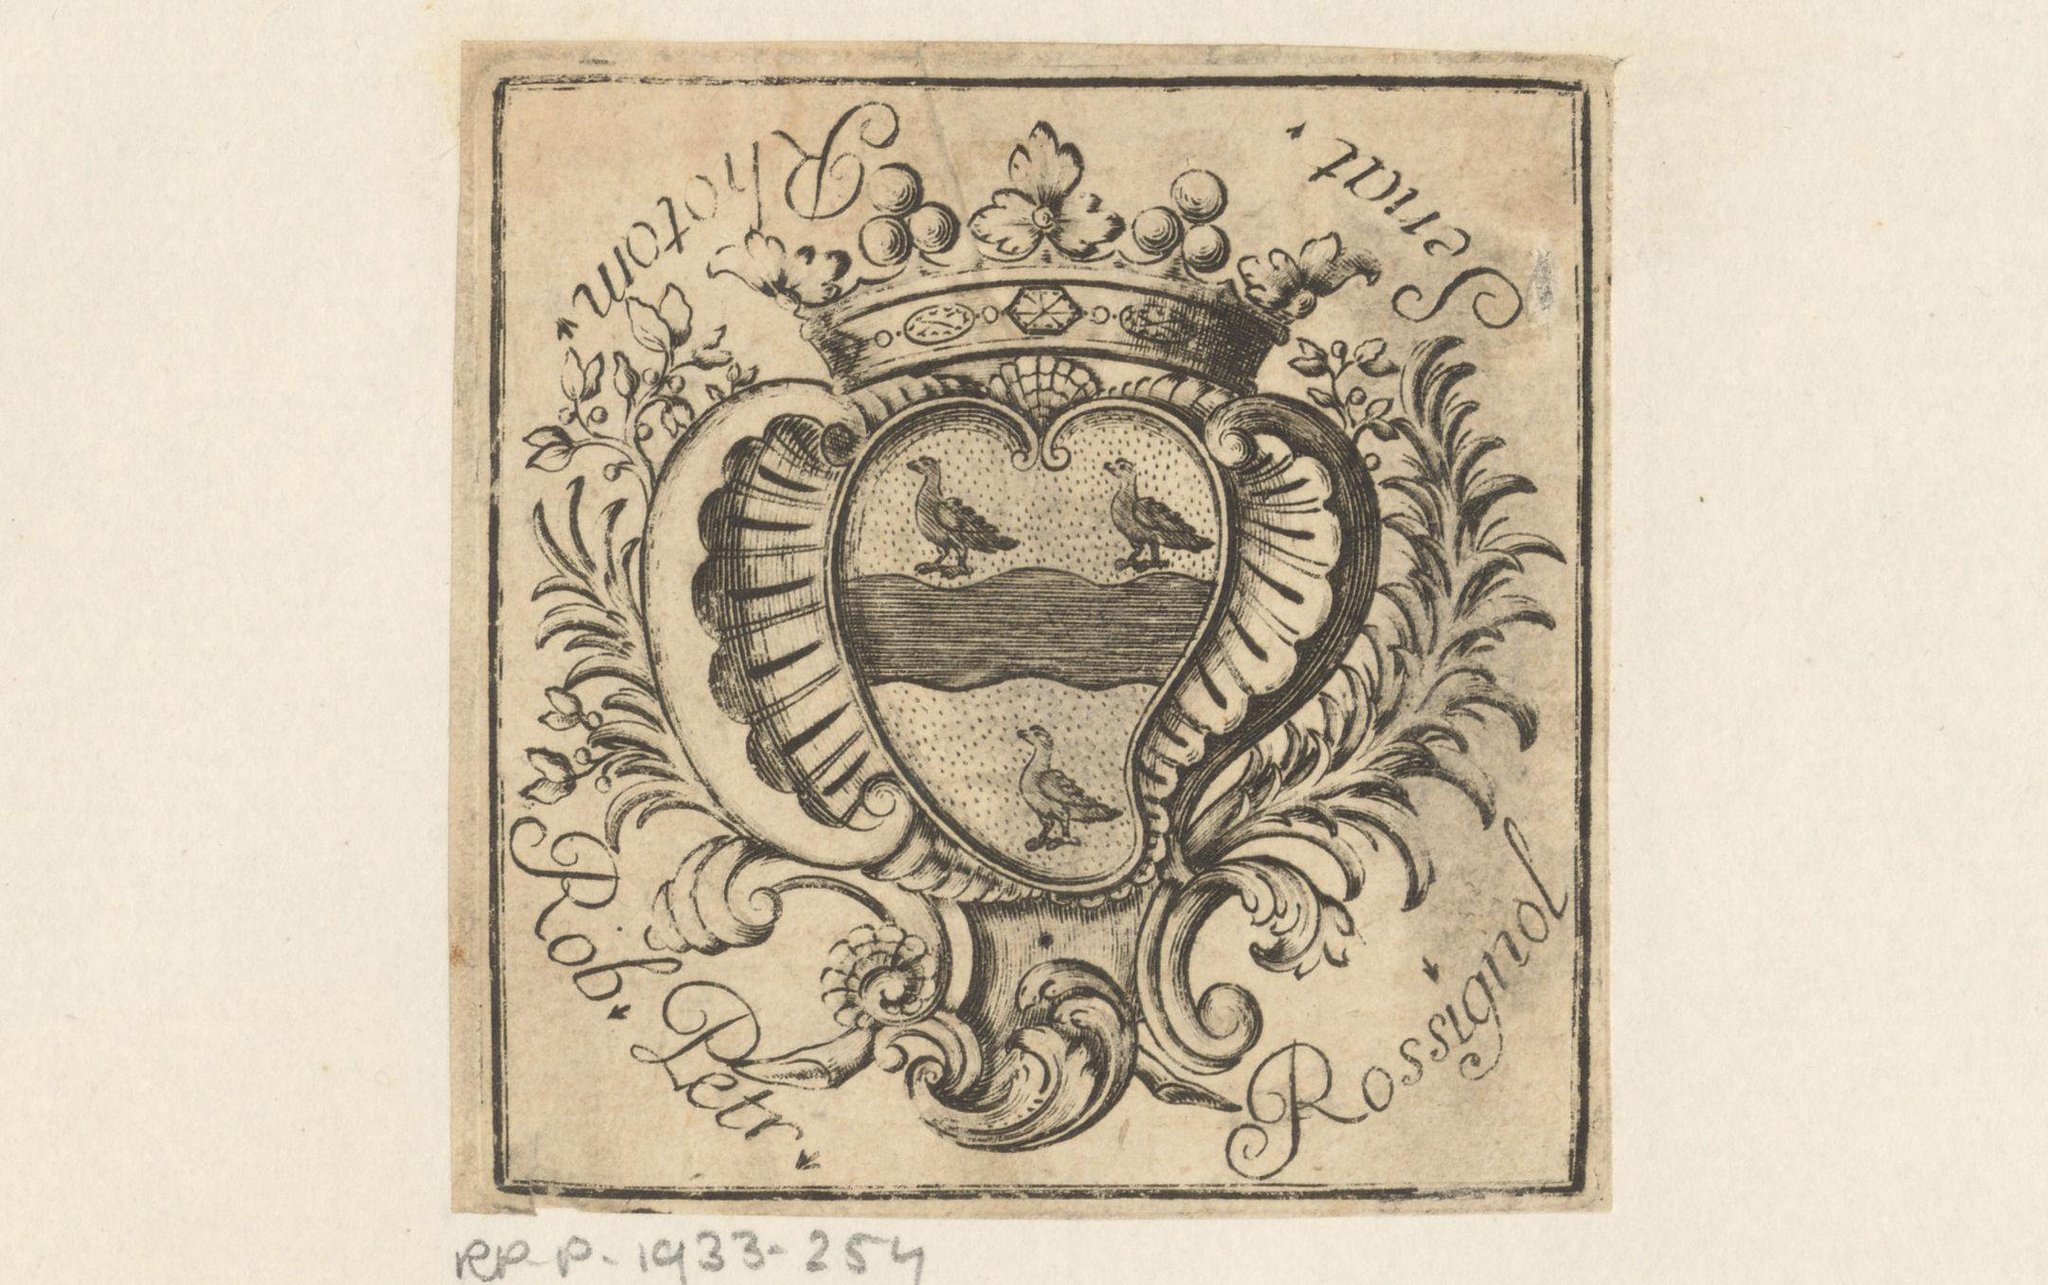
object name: bookplate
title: Ex libris van Robert Pierre Rossignol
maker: Anonymous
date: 1675-1749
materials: paper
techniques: etching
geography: france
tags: rocaille ornament, birds, armorial bearing, heraldry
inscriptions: collector's mark: Lugt 2760